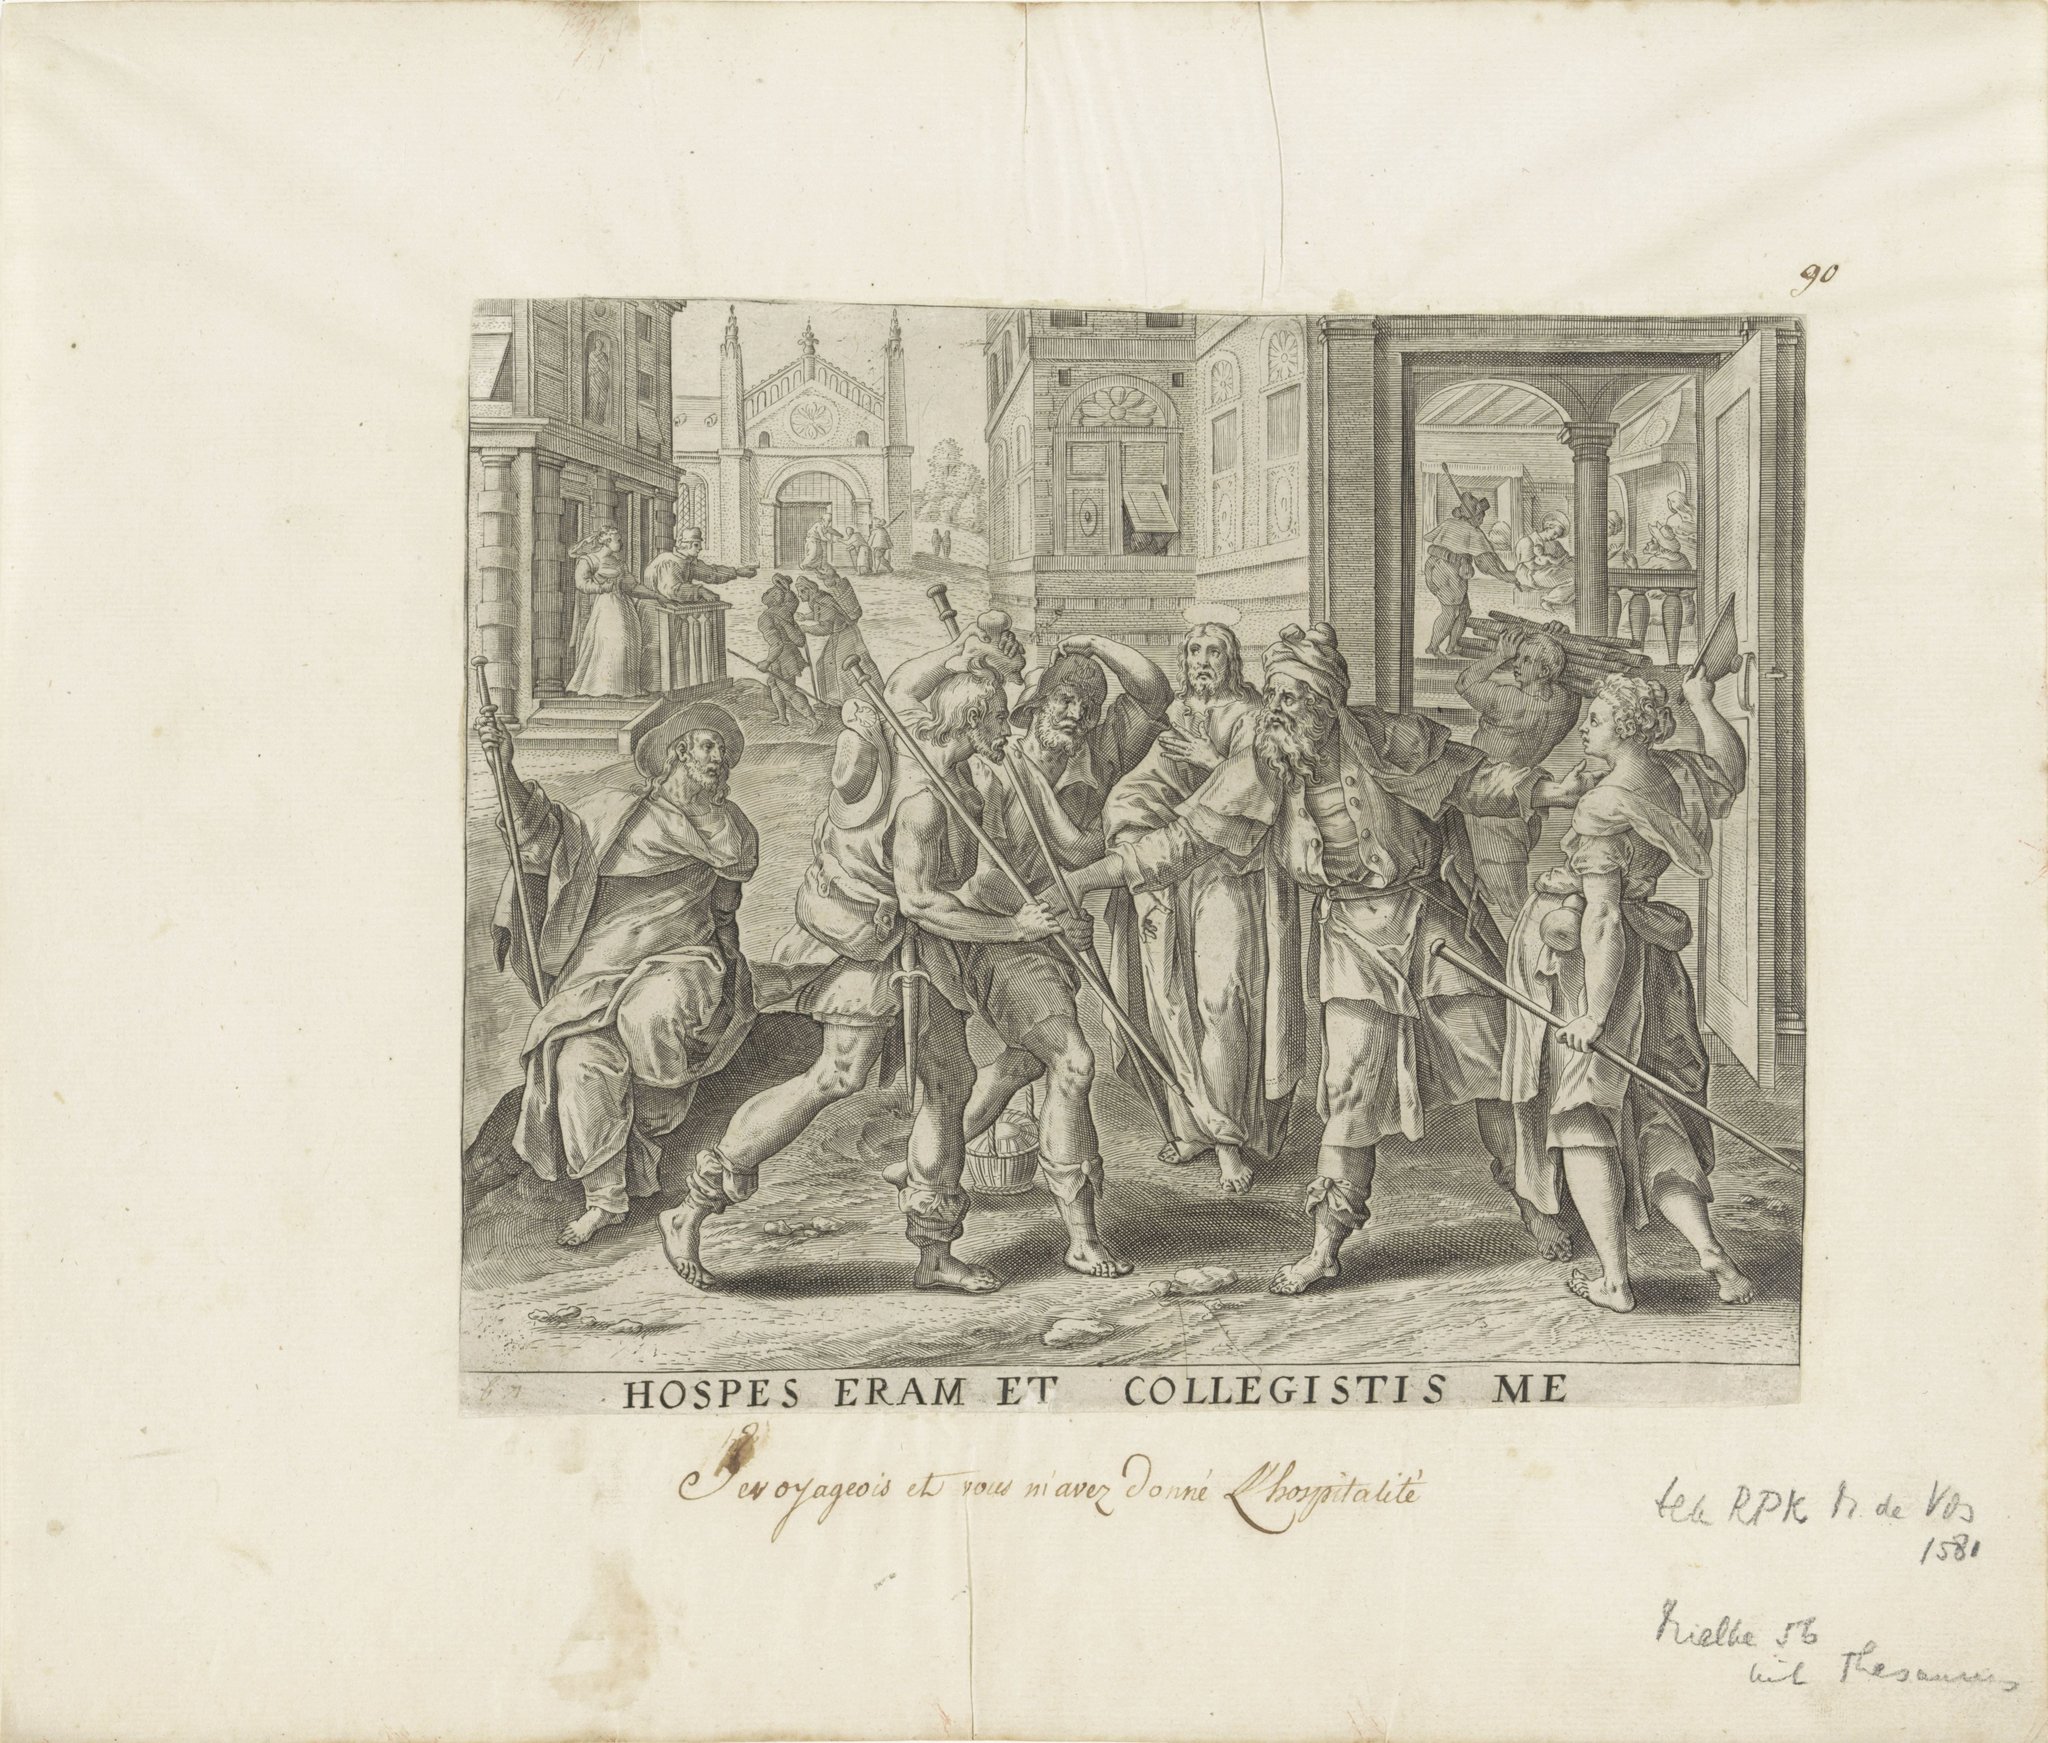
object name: print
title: Zeven werken van barmhartigheid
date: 1585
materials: paper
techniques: engraving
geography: antwerp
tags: sheltering strangers, 'hospes colligitur' ~ one of the (seven) acts of mercy - vv - christ present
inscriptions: collector's mark: Lugt 2228, number: ‘90’, inscription: ‘Je voyageois et vous m'avez donné l'hositalité’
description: Een man verwelkomt met open armen vreemdelingen en pelgrims. Christus staat links achter hem. Rechts zicht in het interieur van een huis. Onder de voorstelling een verwijzing in het Latijn naar de Bijbeltekst.